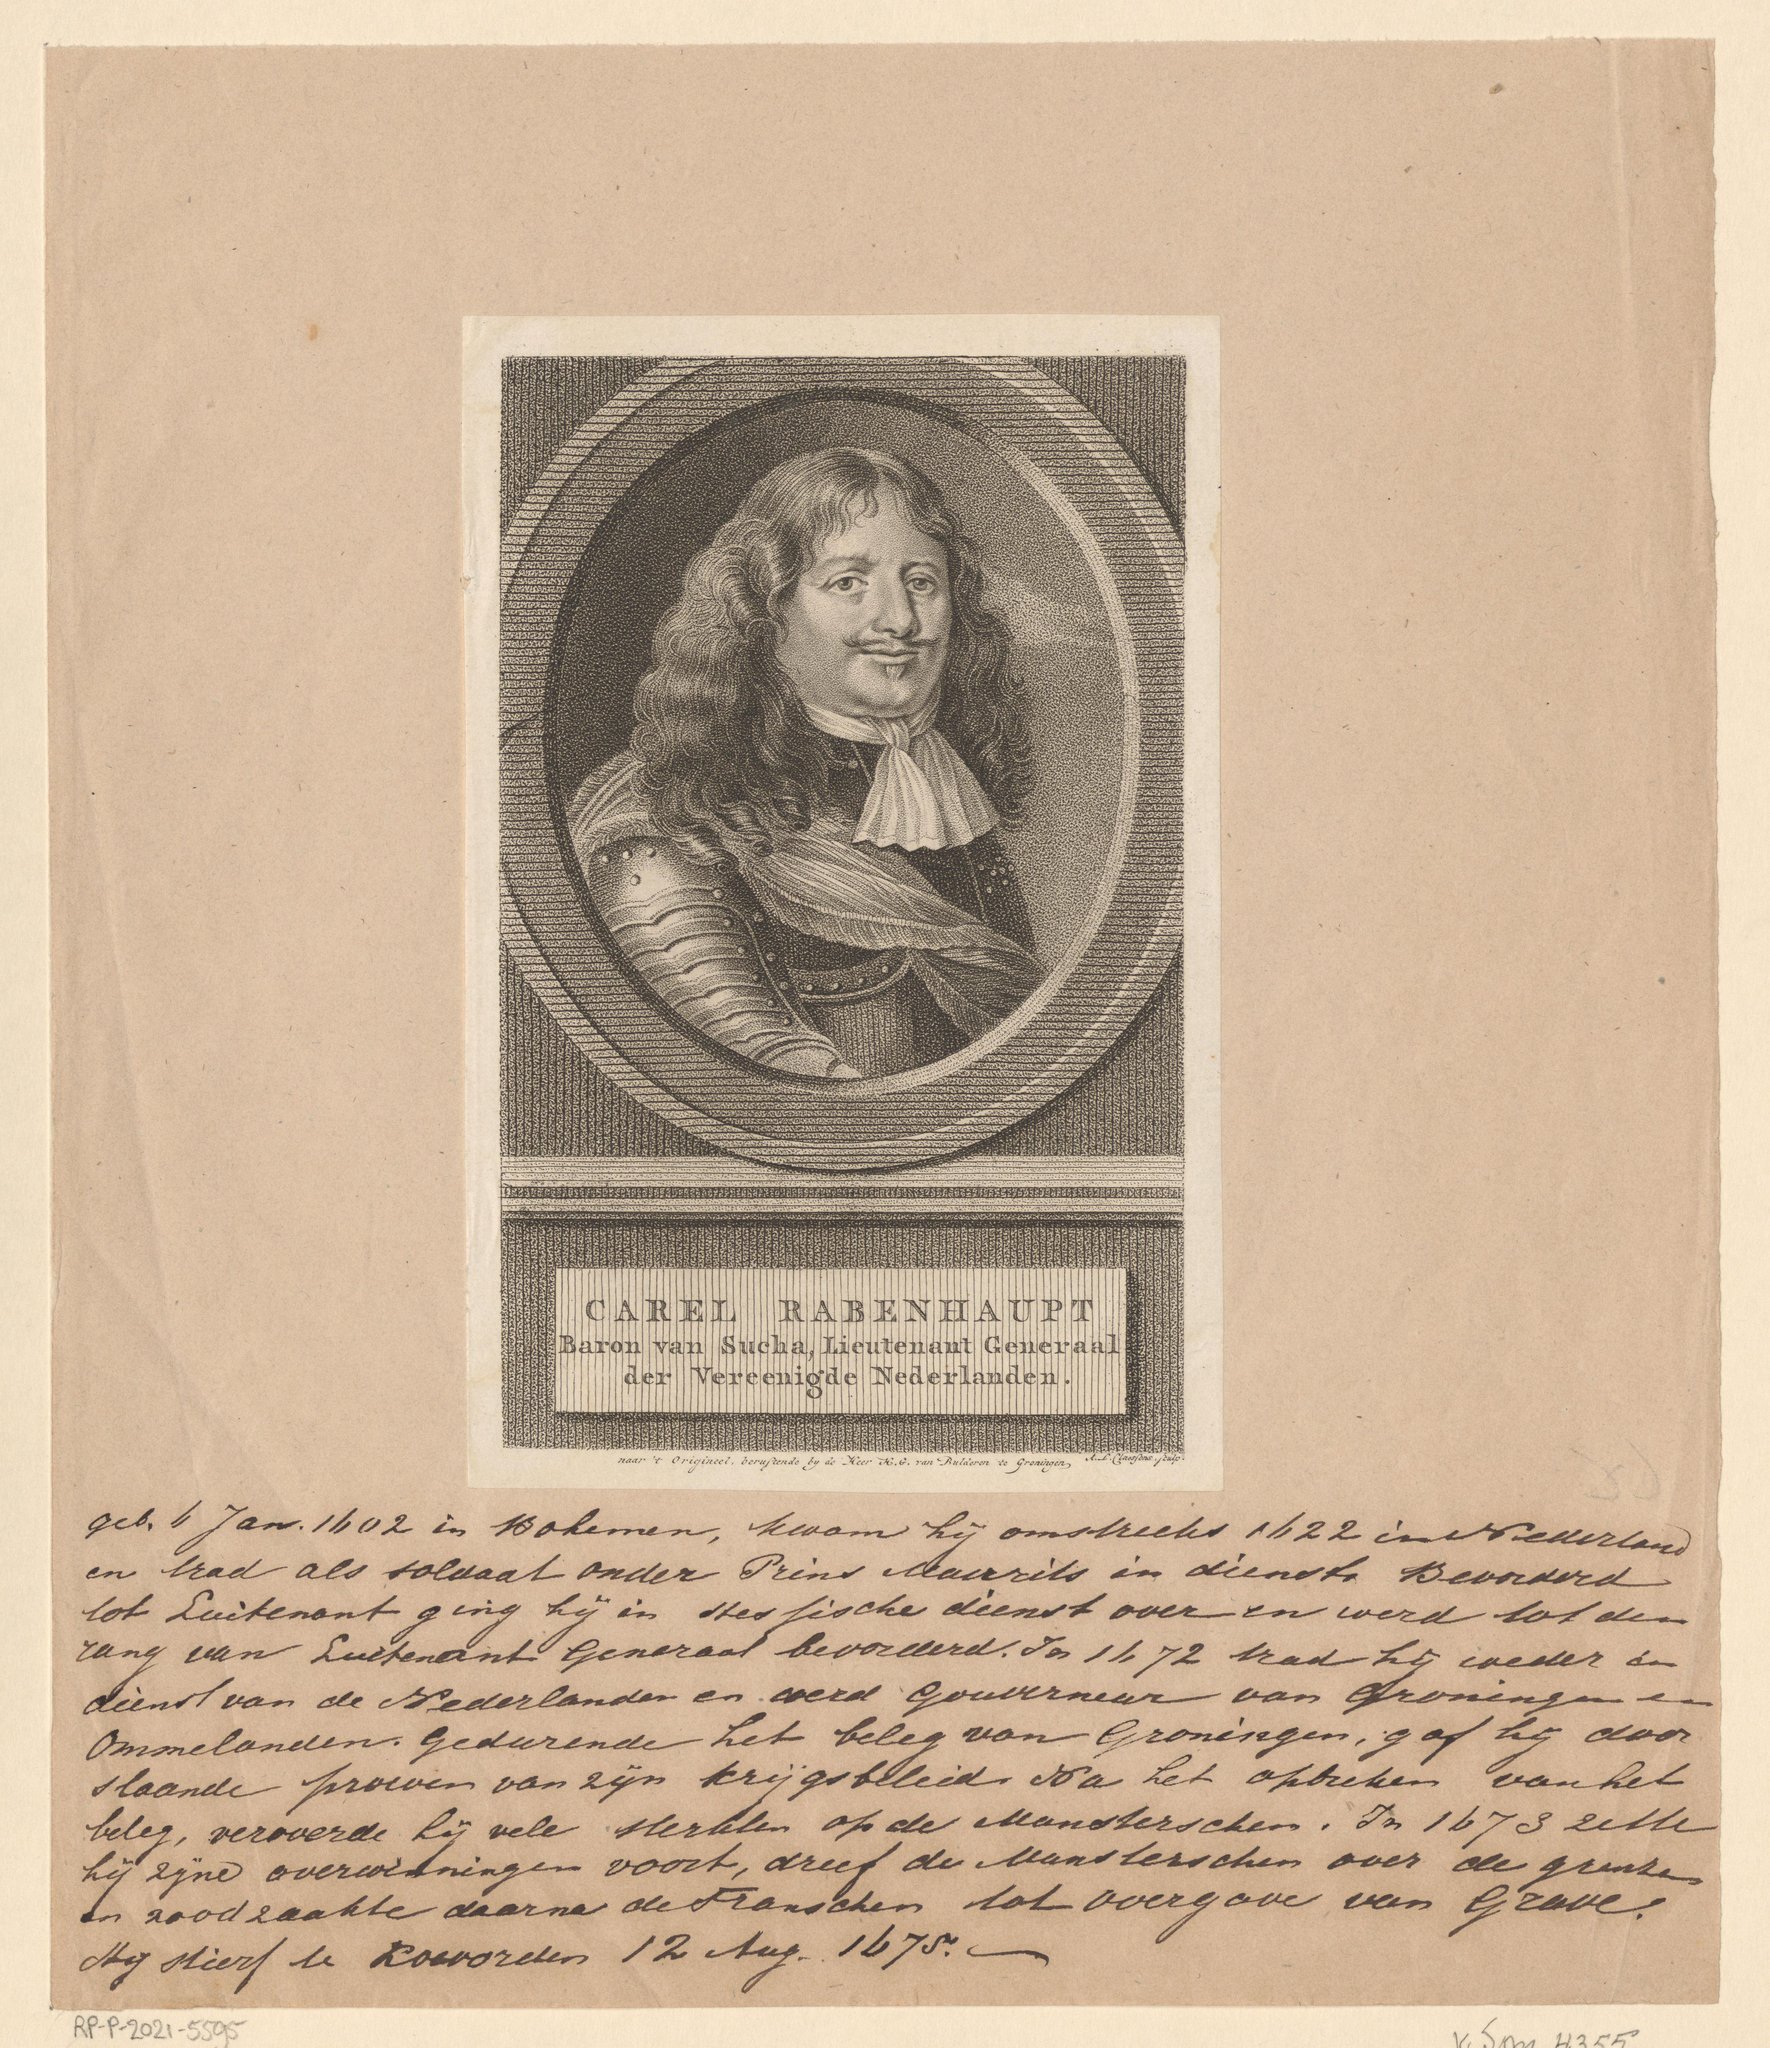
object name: print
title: Portret van Karl Rabenhaupt, baron von Sucha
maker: lambertus antonius claessens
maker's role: draughtsman, print maker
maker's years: 1763-1834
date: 1794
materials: paper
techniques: engraving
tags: harness, historical persons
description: Prent mogelijk uit: Wagenaar, Jan. Vaderlandsche historie, vervattende de geschiedenissen (...). Amsterdam: Johannes Allart, 1794.